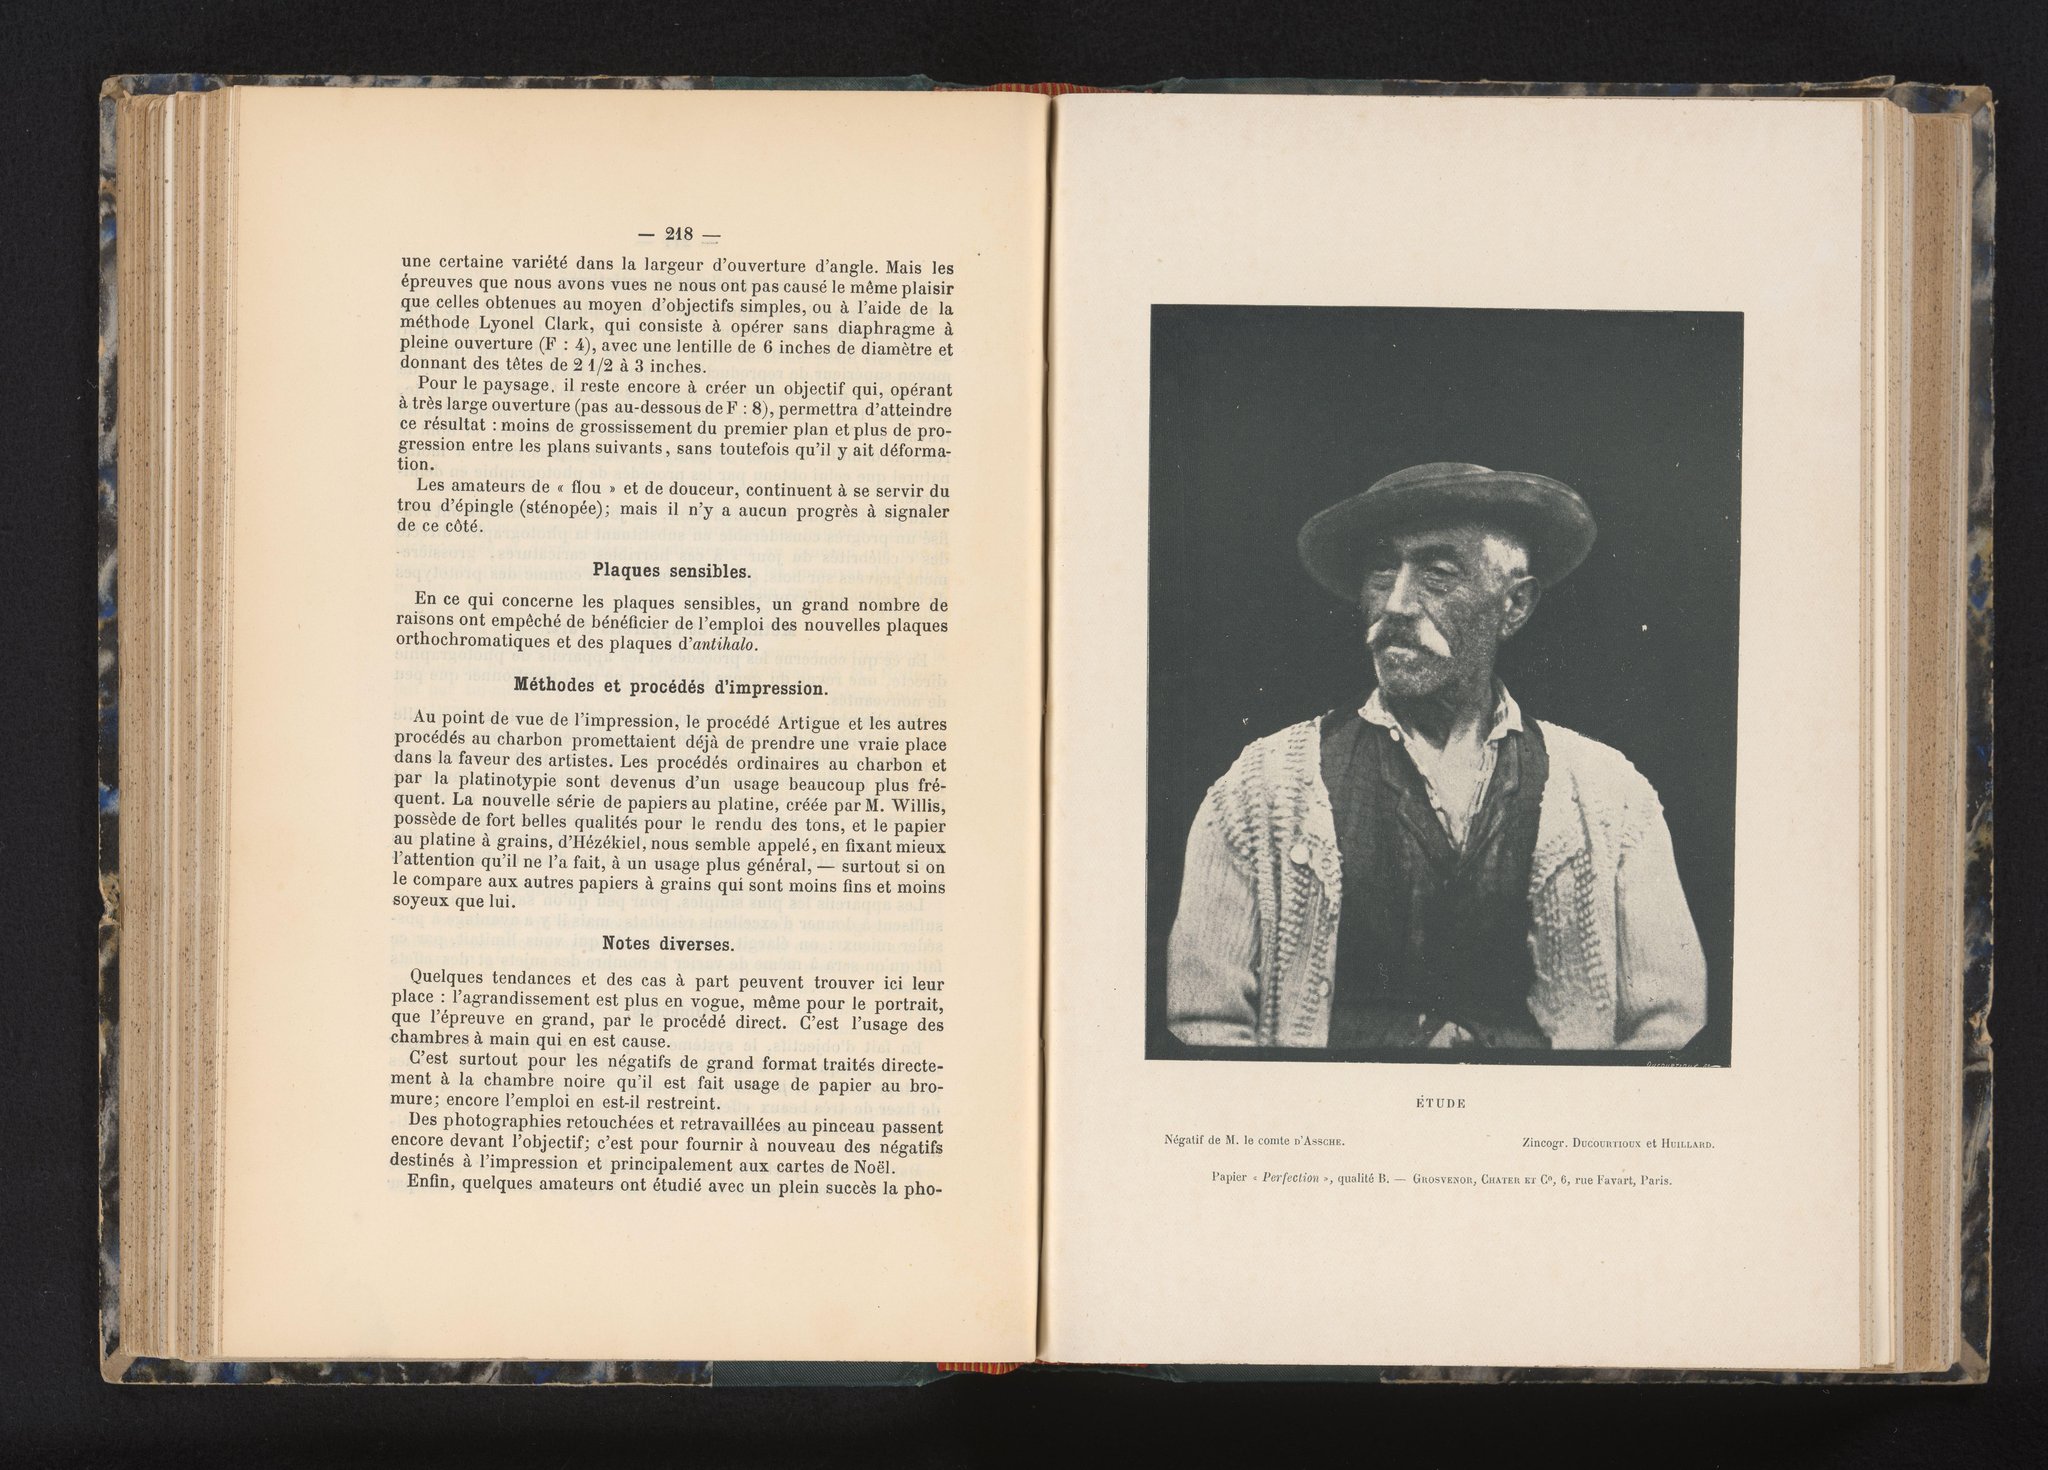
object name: photomechanical print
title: Étude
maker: comte d assche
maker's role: fotograaf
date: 1891-1896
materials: paper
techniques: autotype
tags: historical persons, head-gear: hat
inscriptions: inscription: ‘Papier < Perfection >, qualité B. - Grosvenor, Charter et Co, 6, rue Favart, Paris.’